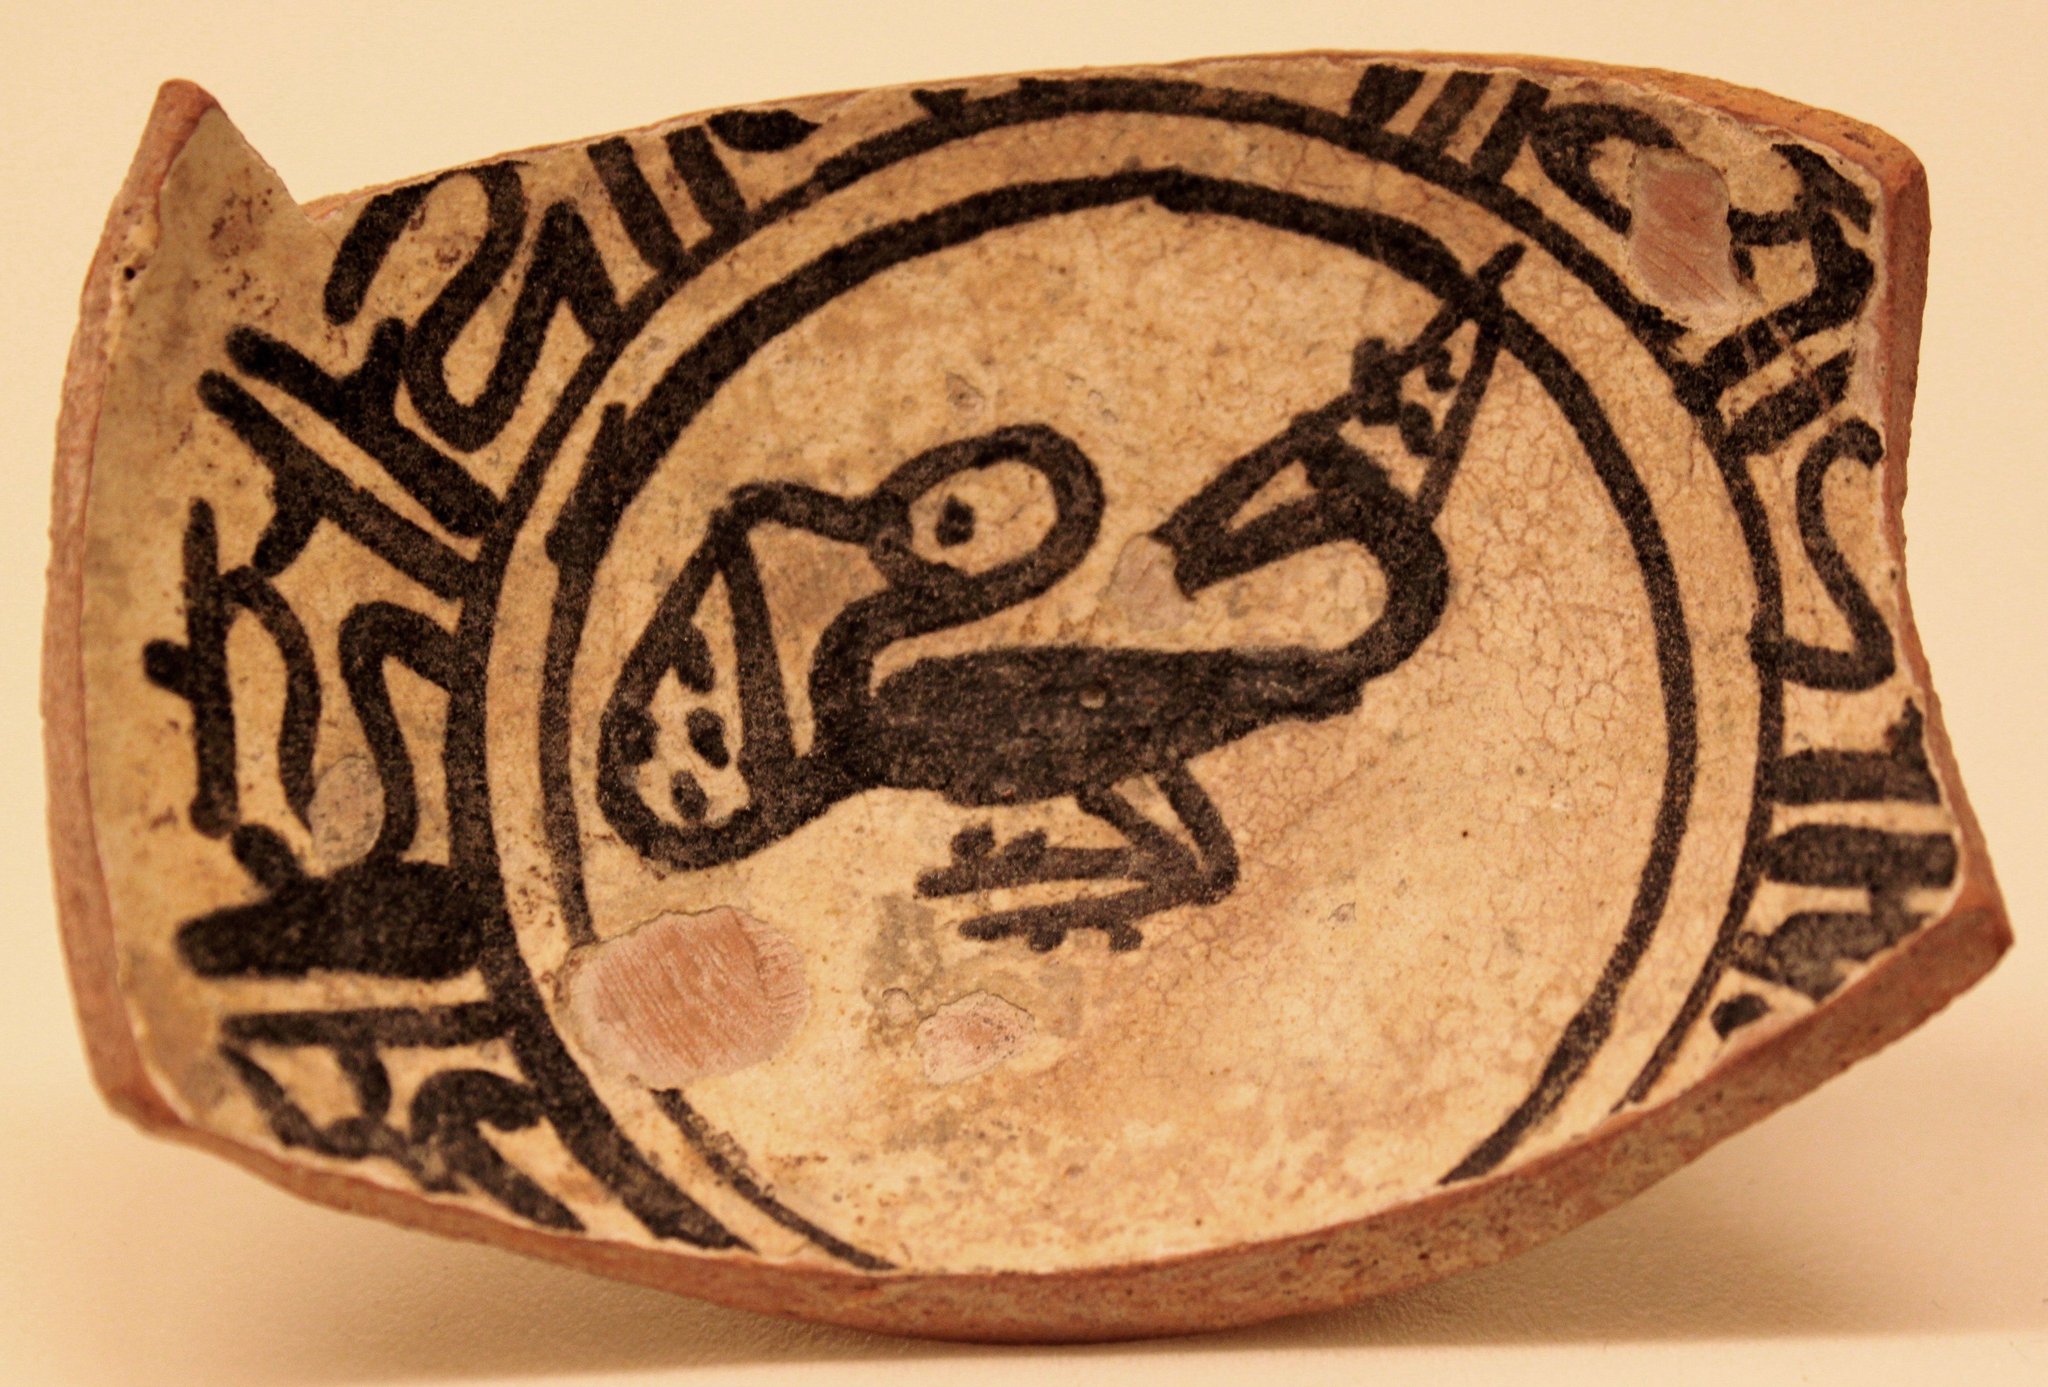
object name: fragment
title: Fragment of a Bowl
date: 801-1000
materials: earthenware, glaze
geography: iran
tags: birds